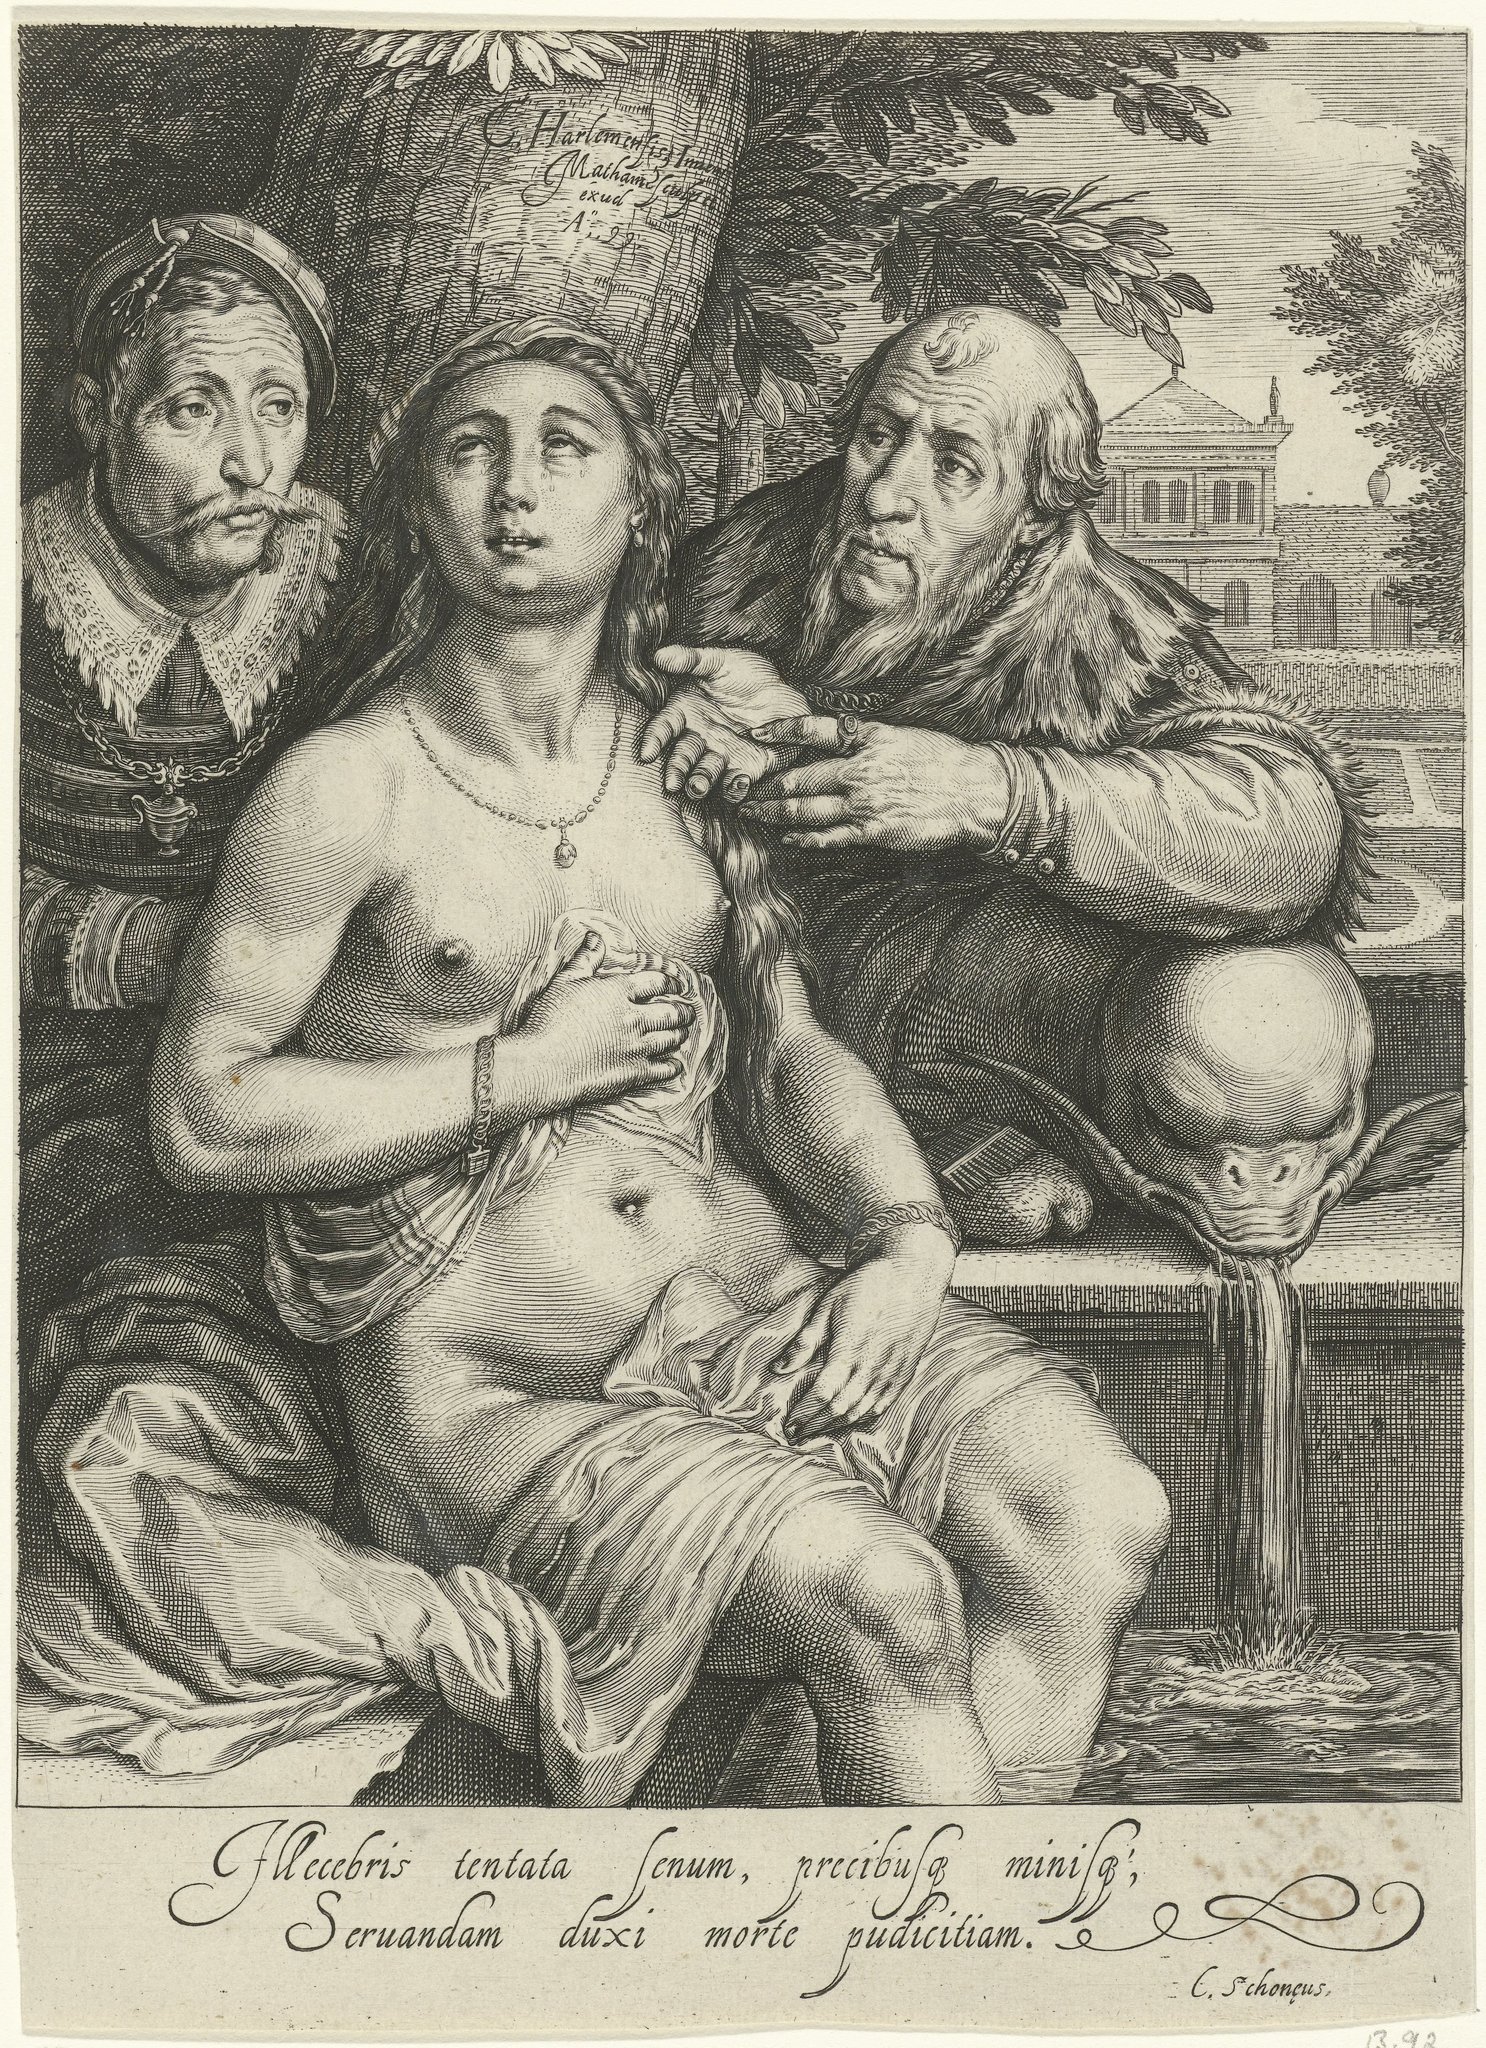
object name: print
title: Suzanna en de ouderlingen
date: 1599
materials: paper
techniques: engraving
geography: haarlem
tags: the elders spying upon susanna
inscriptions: collector's mark: Lugt 240